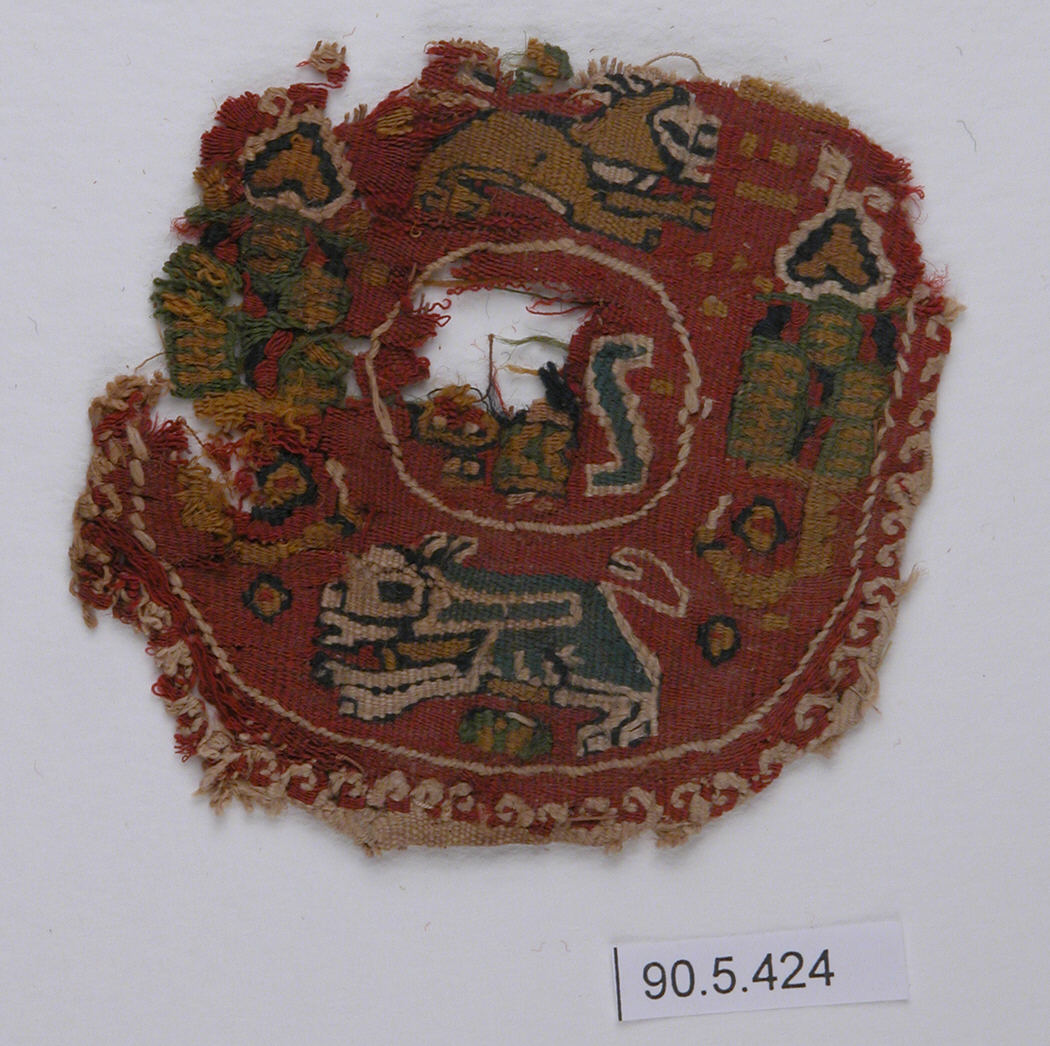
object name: textile fragment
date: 401-600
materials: linen, wool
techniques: weave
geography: egypt